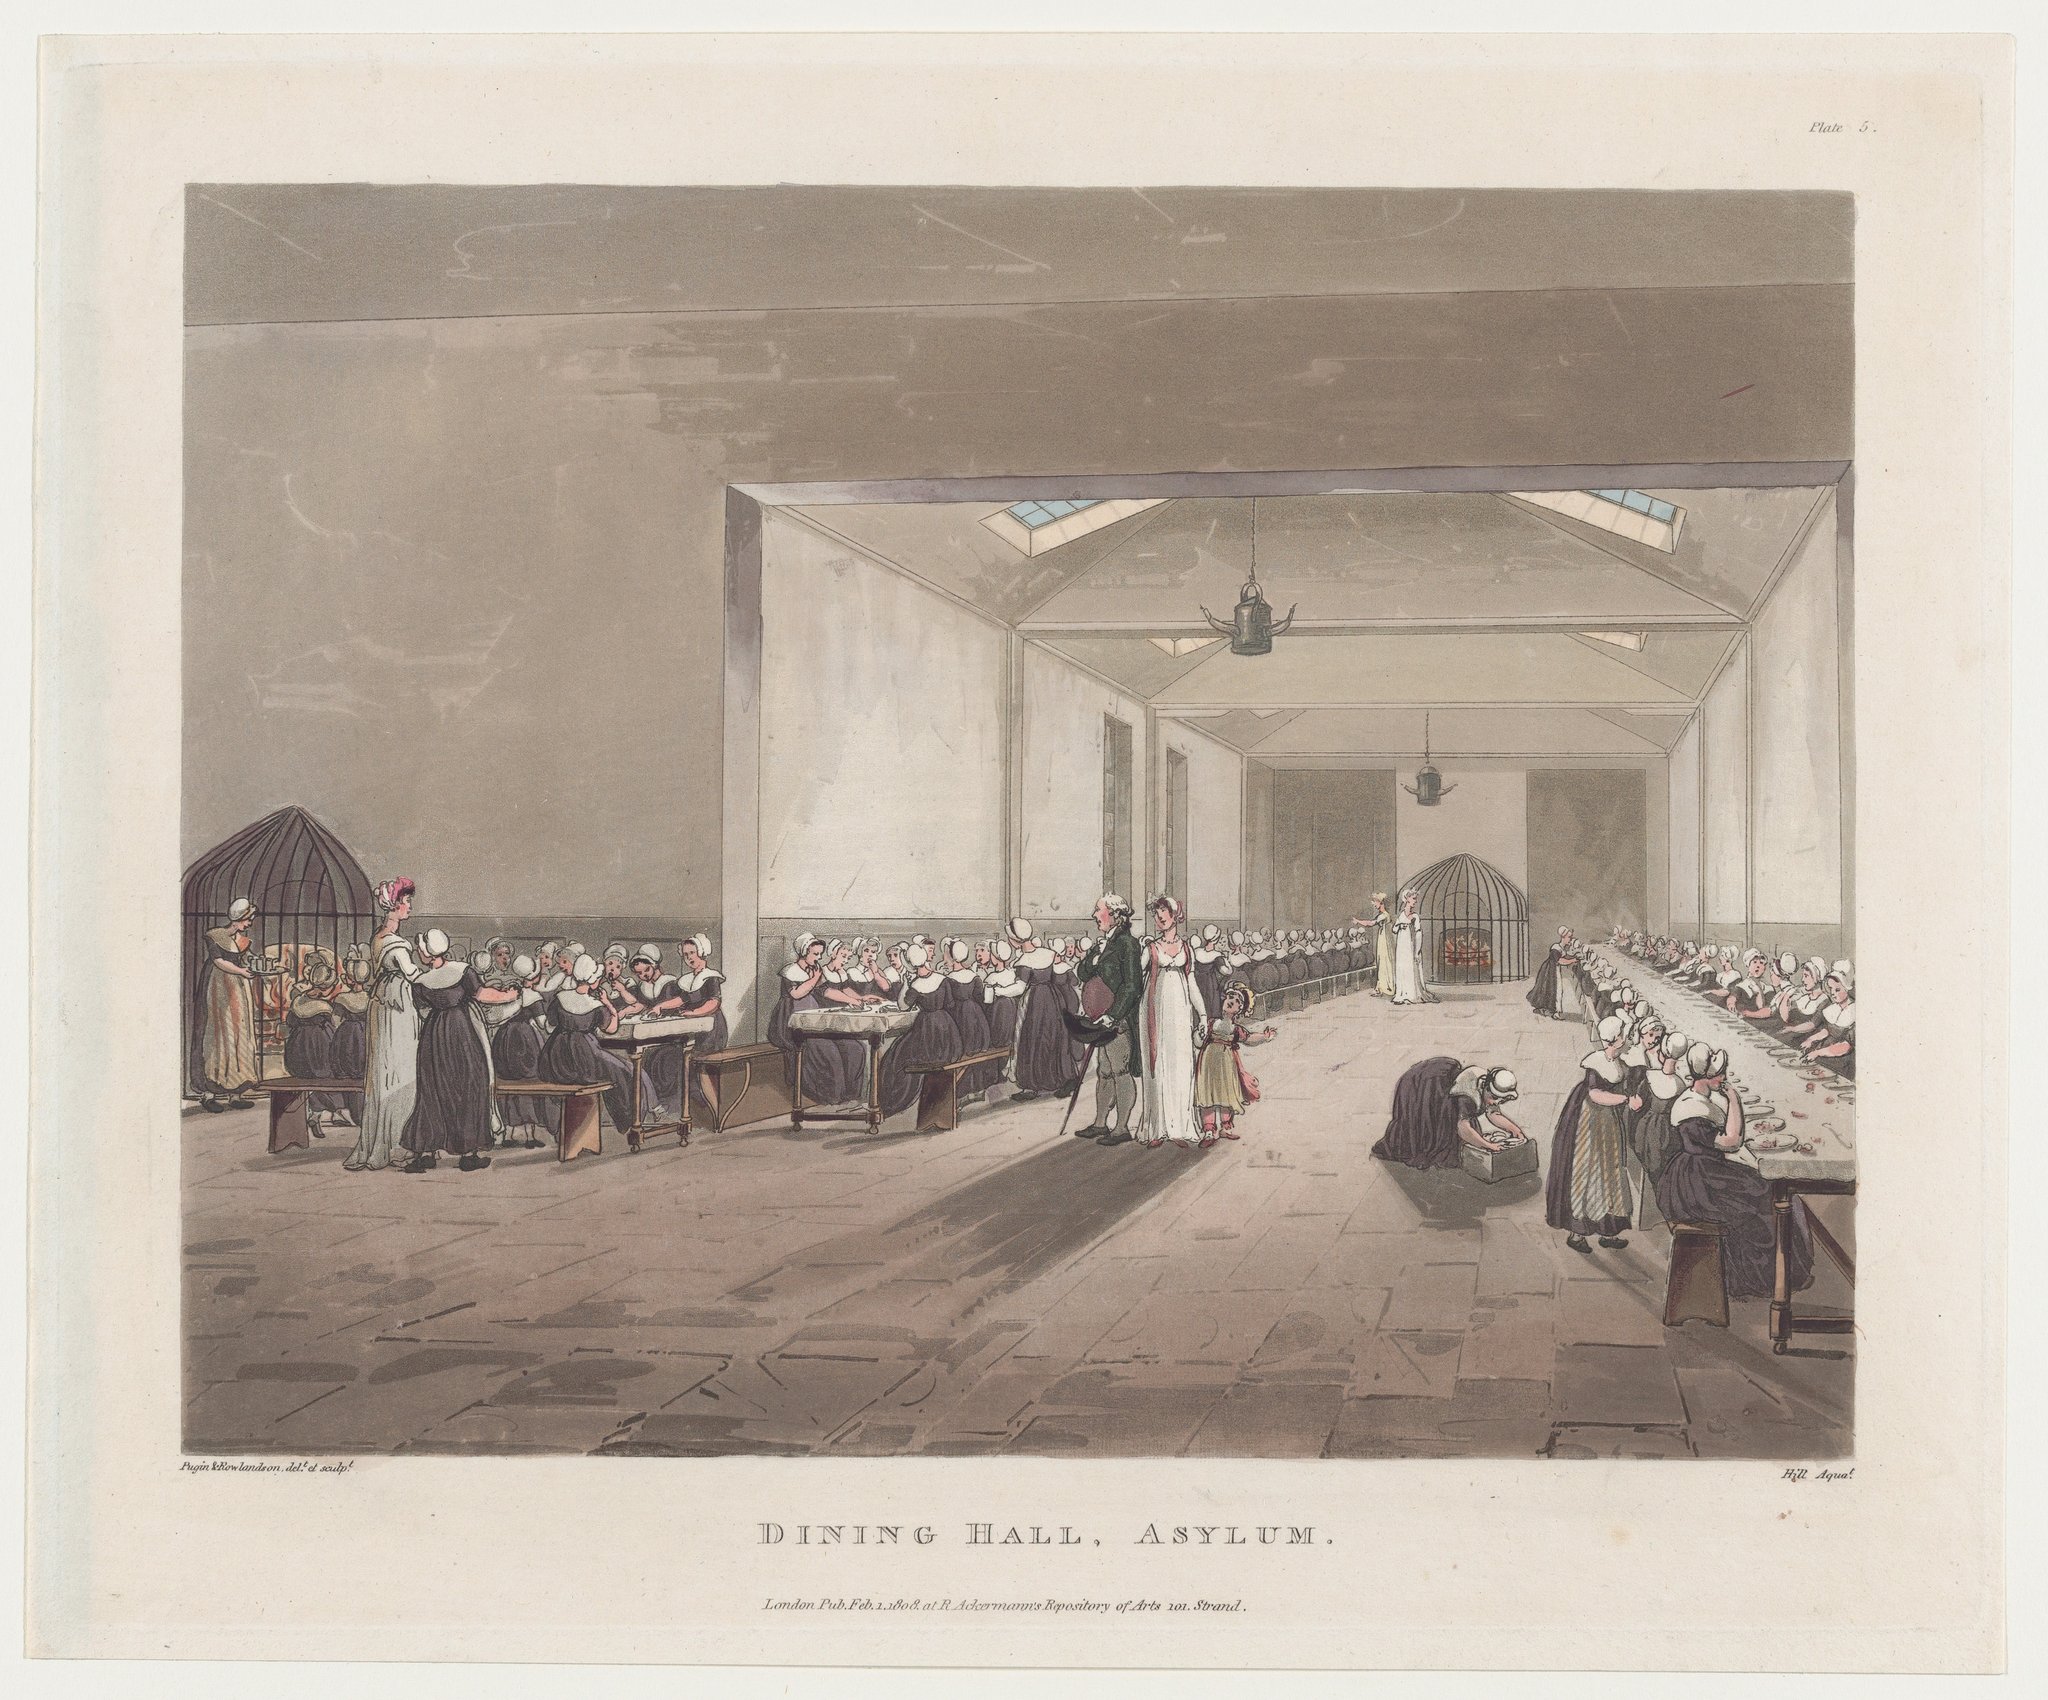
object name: print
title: Dining Hall, Asylum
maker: thomas rowlandson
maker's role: artist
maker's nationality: british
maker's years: 1757-1827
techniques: aquatint, etching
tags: interiors,women,dining